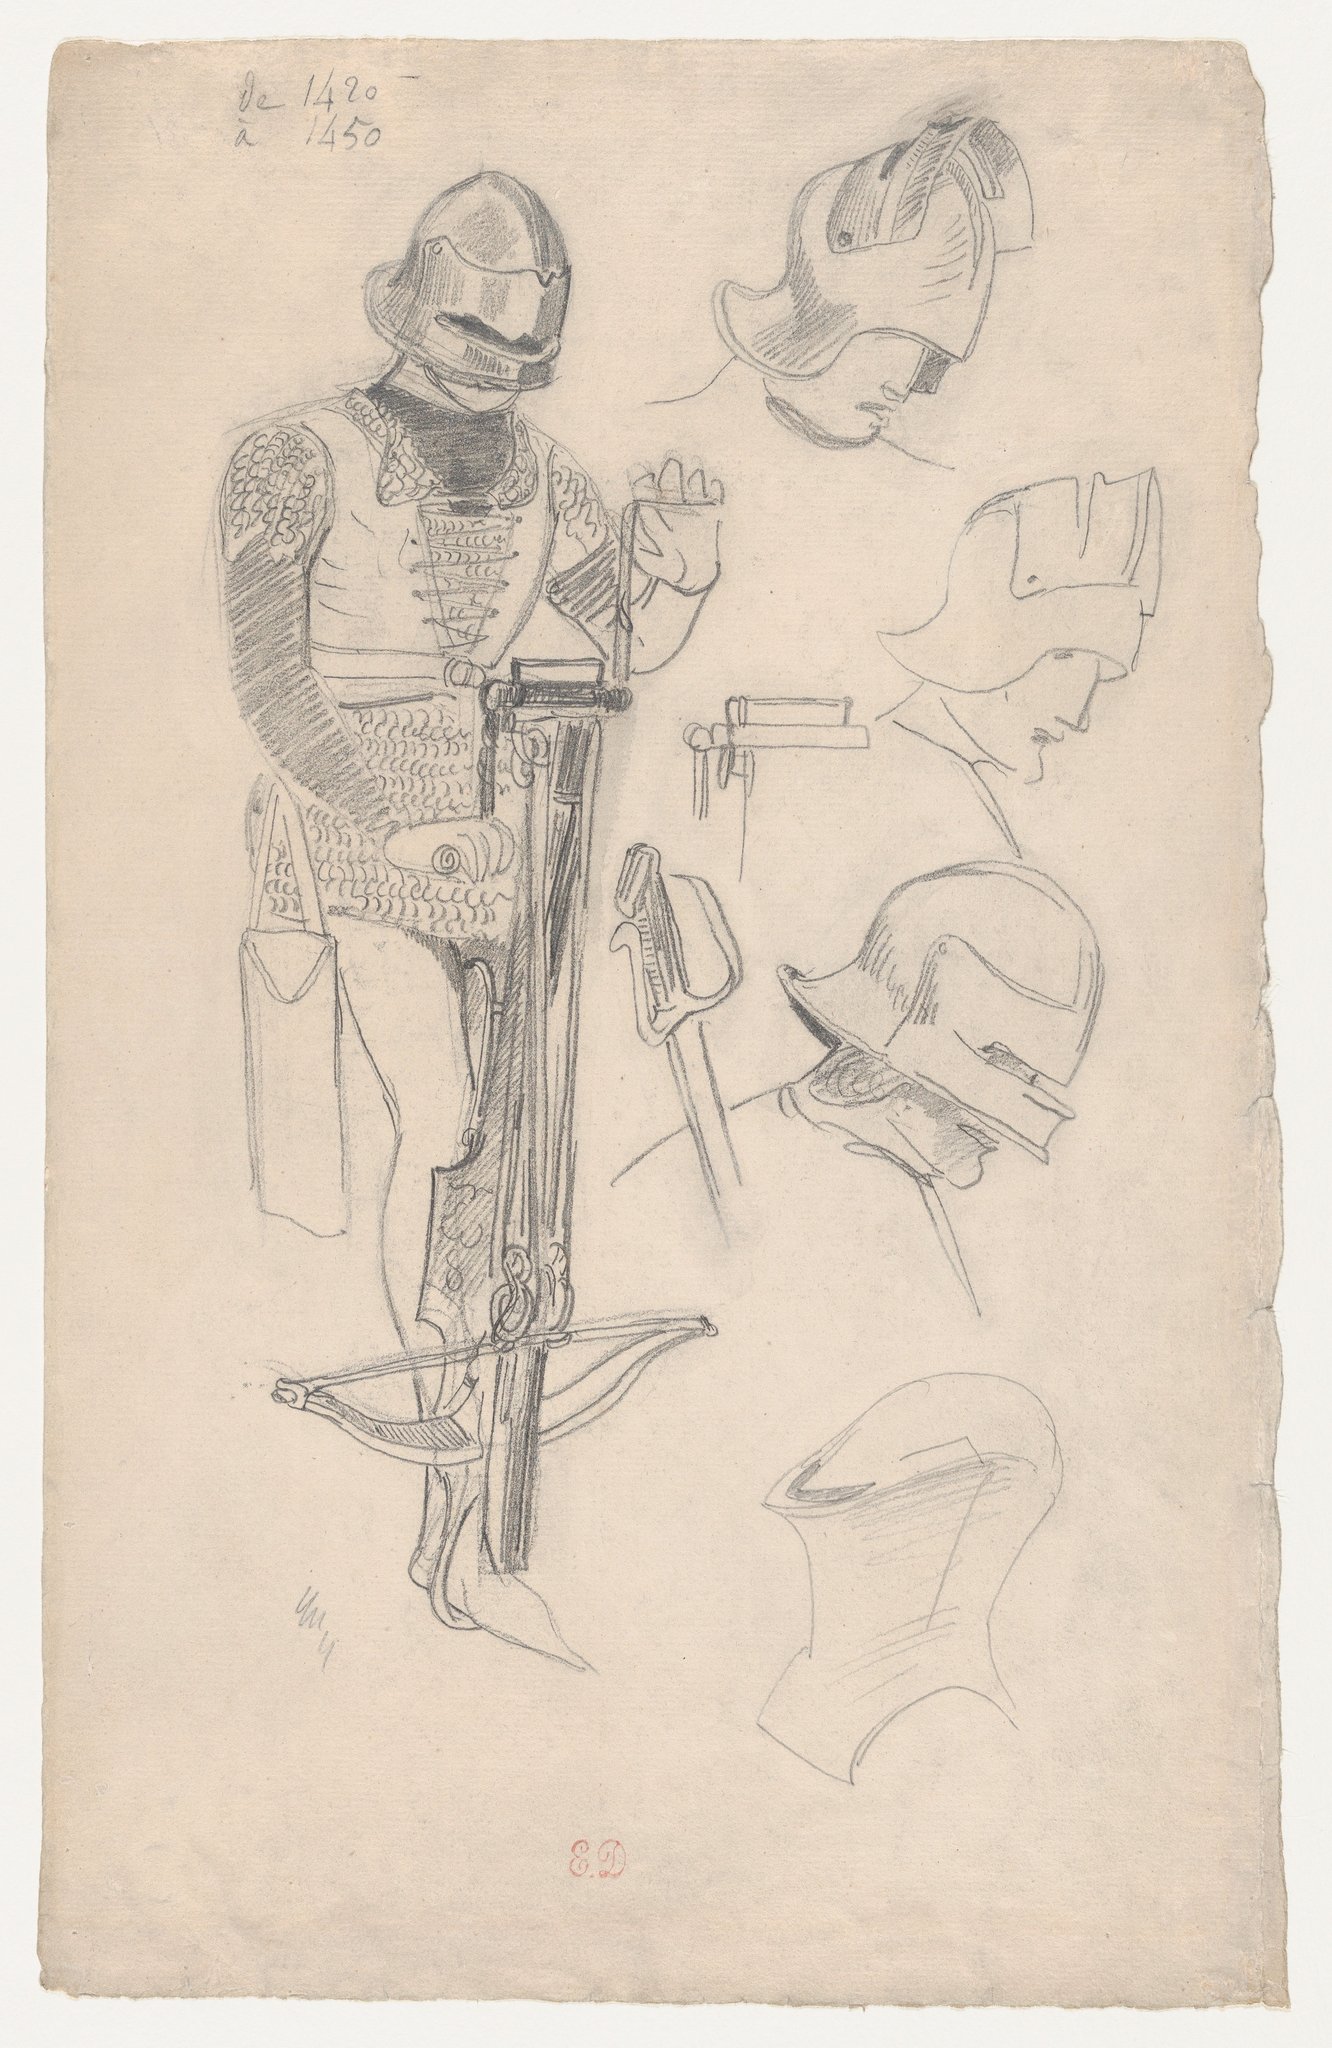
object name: drawing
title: Study of Medieval Armor and a Crossbow (recto); Studies of a Medieval Helmet (verso)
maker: eugène delacroix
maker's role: artist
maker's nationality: french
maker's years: 1798-1863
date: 1825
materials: graphite